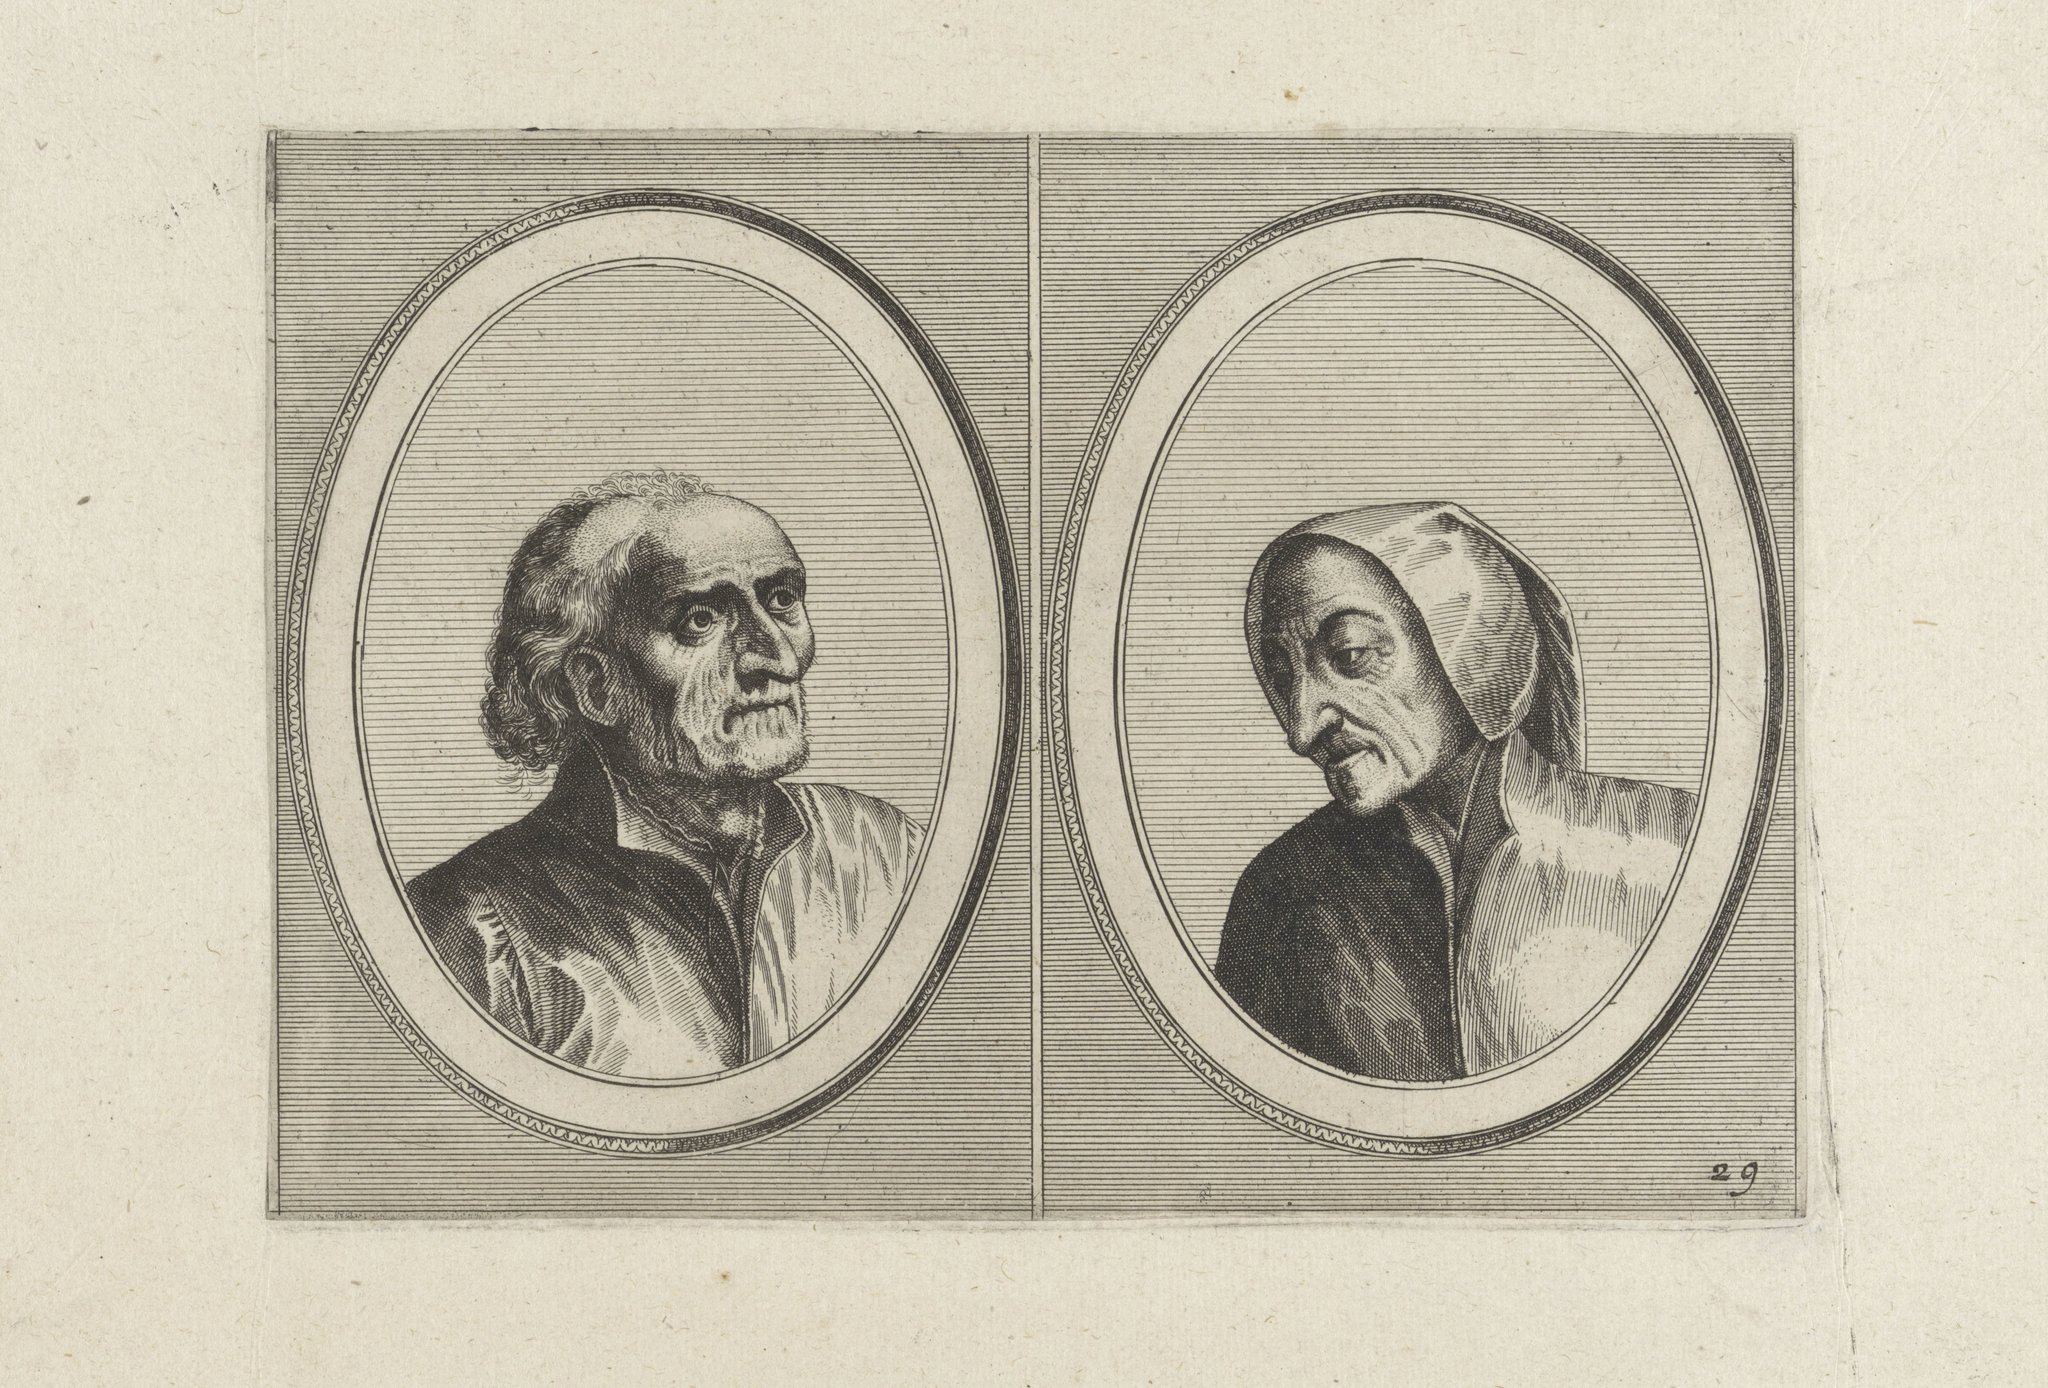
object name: print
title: 't Suynighe Waertje en De Goelijcke Waerdin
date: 1612-1652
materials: paper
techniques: engraving, etching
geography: amsterdam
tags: head-gear, farmers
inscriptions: collector's mark: Lugt 240, collector's mark: Lugt 700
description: Prent uit een serie van 36 prenten met koppen van boeren en boerinnen.